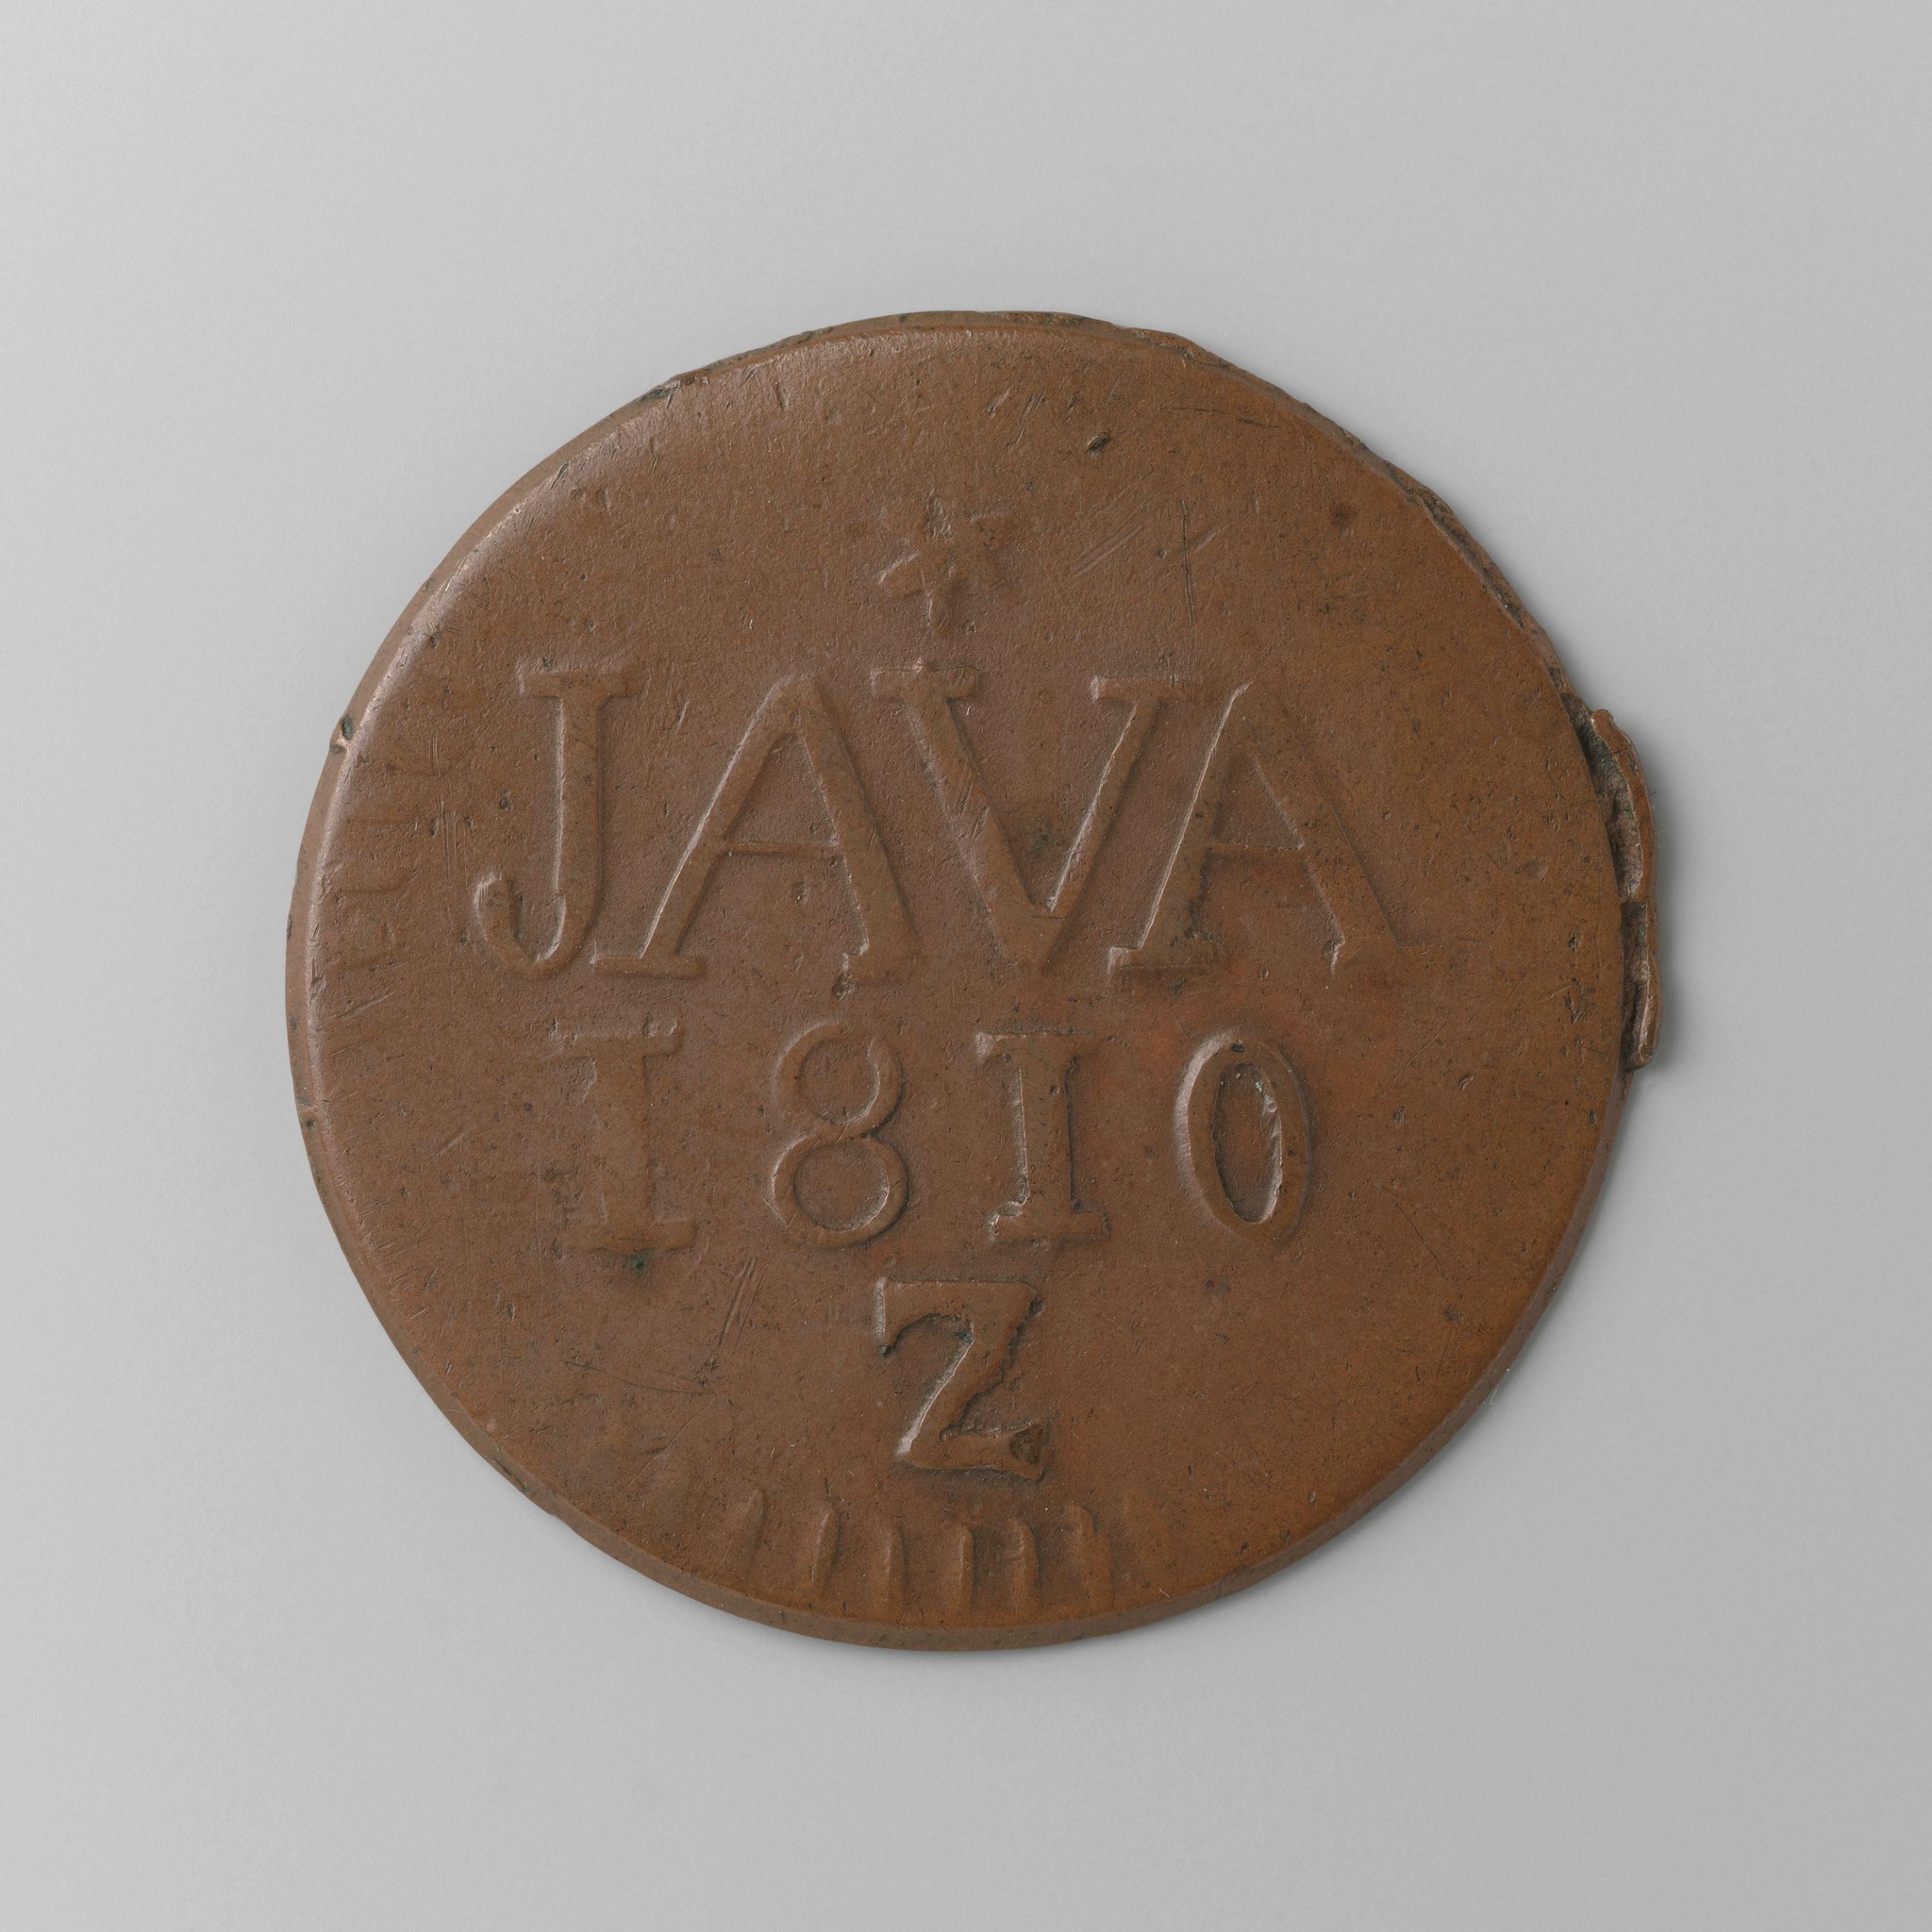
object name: halve stuiver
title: Nederlands Indië, ½ stuiver Java, 1810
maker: louis napoleon (king of holland)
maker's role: koning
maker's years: 1778-1846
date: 1810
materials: copper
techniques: striking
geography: surabaya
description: Koperen munt. Voorzijde: tussen waarde/aanduiding ½ St ineen gestrengelde initialen L en N van Lodewijk Napoleon. Daarboven muntteken. Keerzijde: eenregelig opschrift, waaronder jaartal. Boven opschrift muntteken en onder jaartal muntmeesterteken Z [=muntmeester Zwekkert].